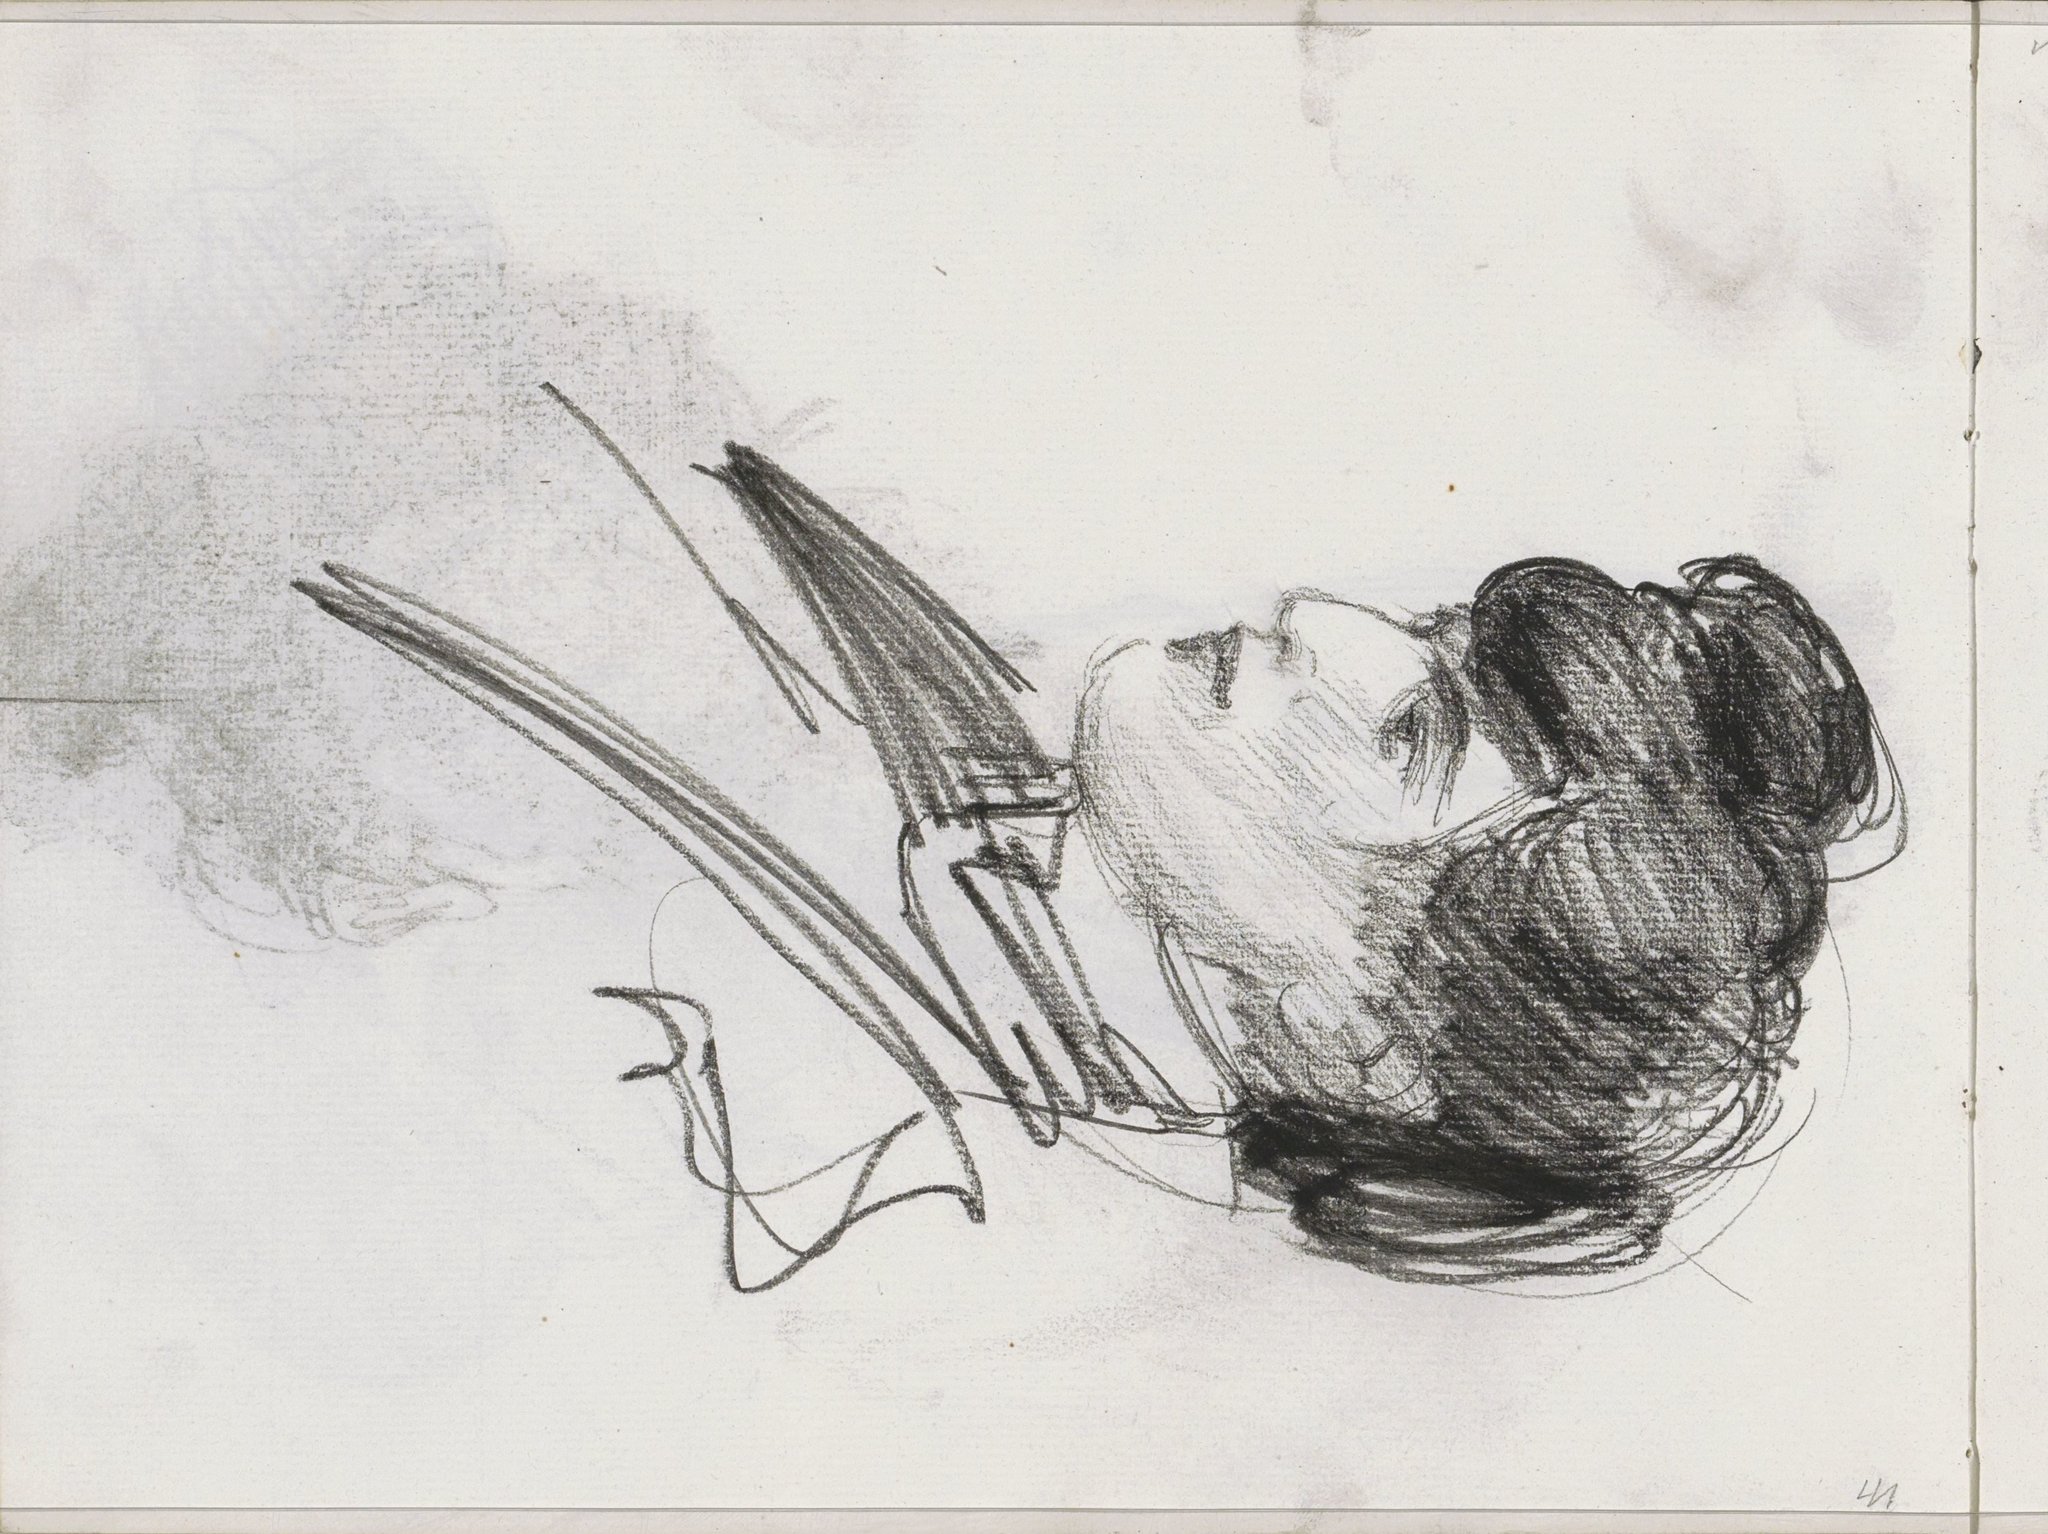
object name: sketchbook leaf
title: Vrouwenhoofd, in profiel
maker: isaac israels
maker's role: draughtsman, painter, print maker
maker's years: 1865-1934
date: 1875-1934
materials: chalk, paper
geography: the hague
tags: head (human) (+ sideview, profile)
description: Blad 10 verso uit schetsboek XXII met 30 bladen.